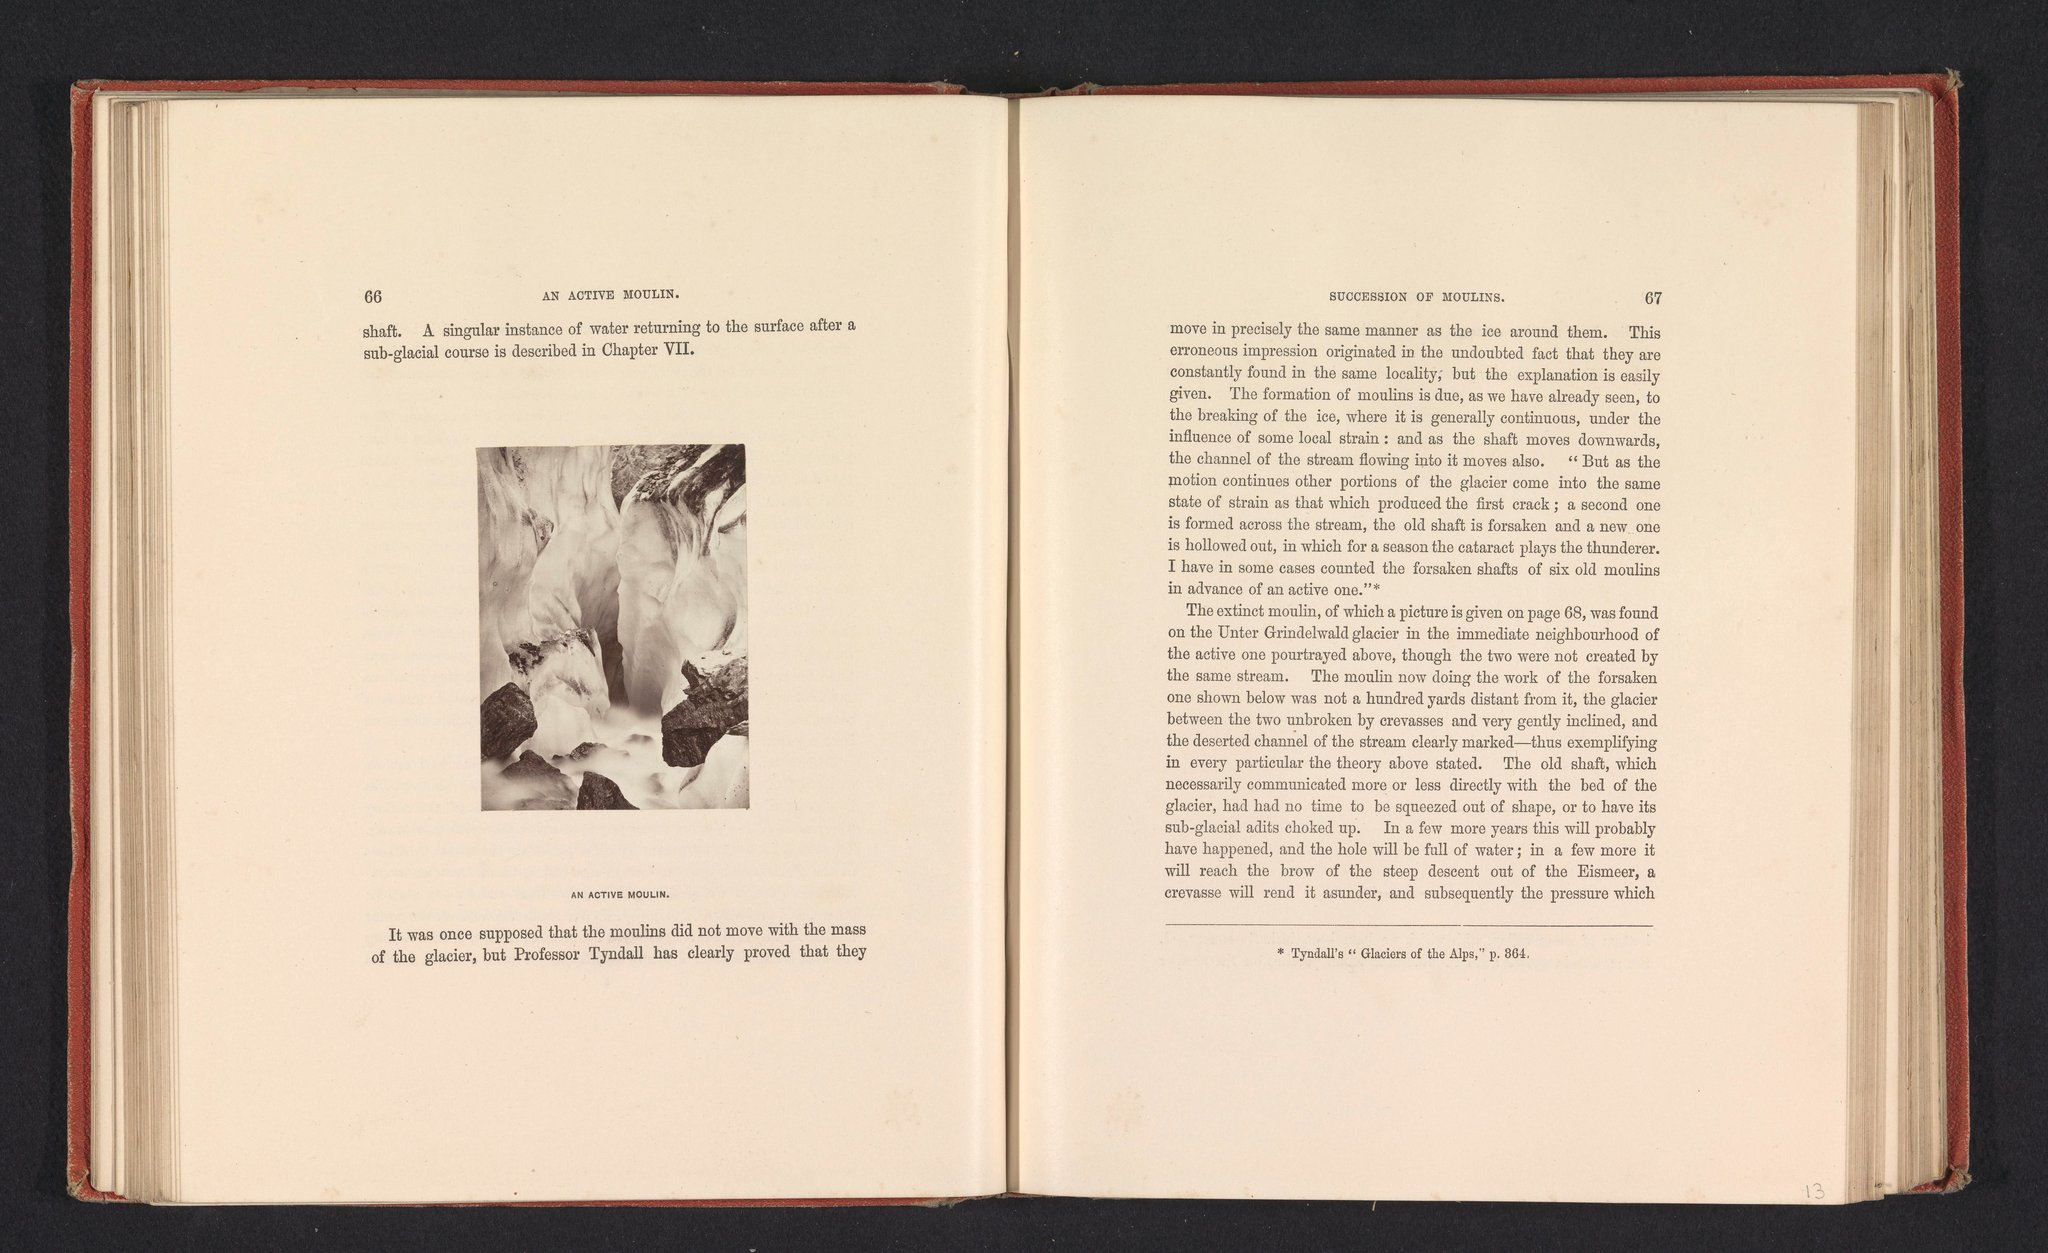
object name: photograph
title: An active moulin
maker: ernest edwards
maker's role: fotograaf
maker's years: 1837-1903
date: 1850-1866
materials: photographic support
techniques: albumen print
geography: bern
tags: glacier, boulder, stone